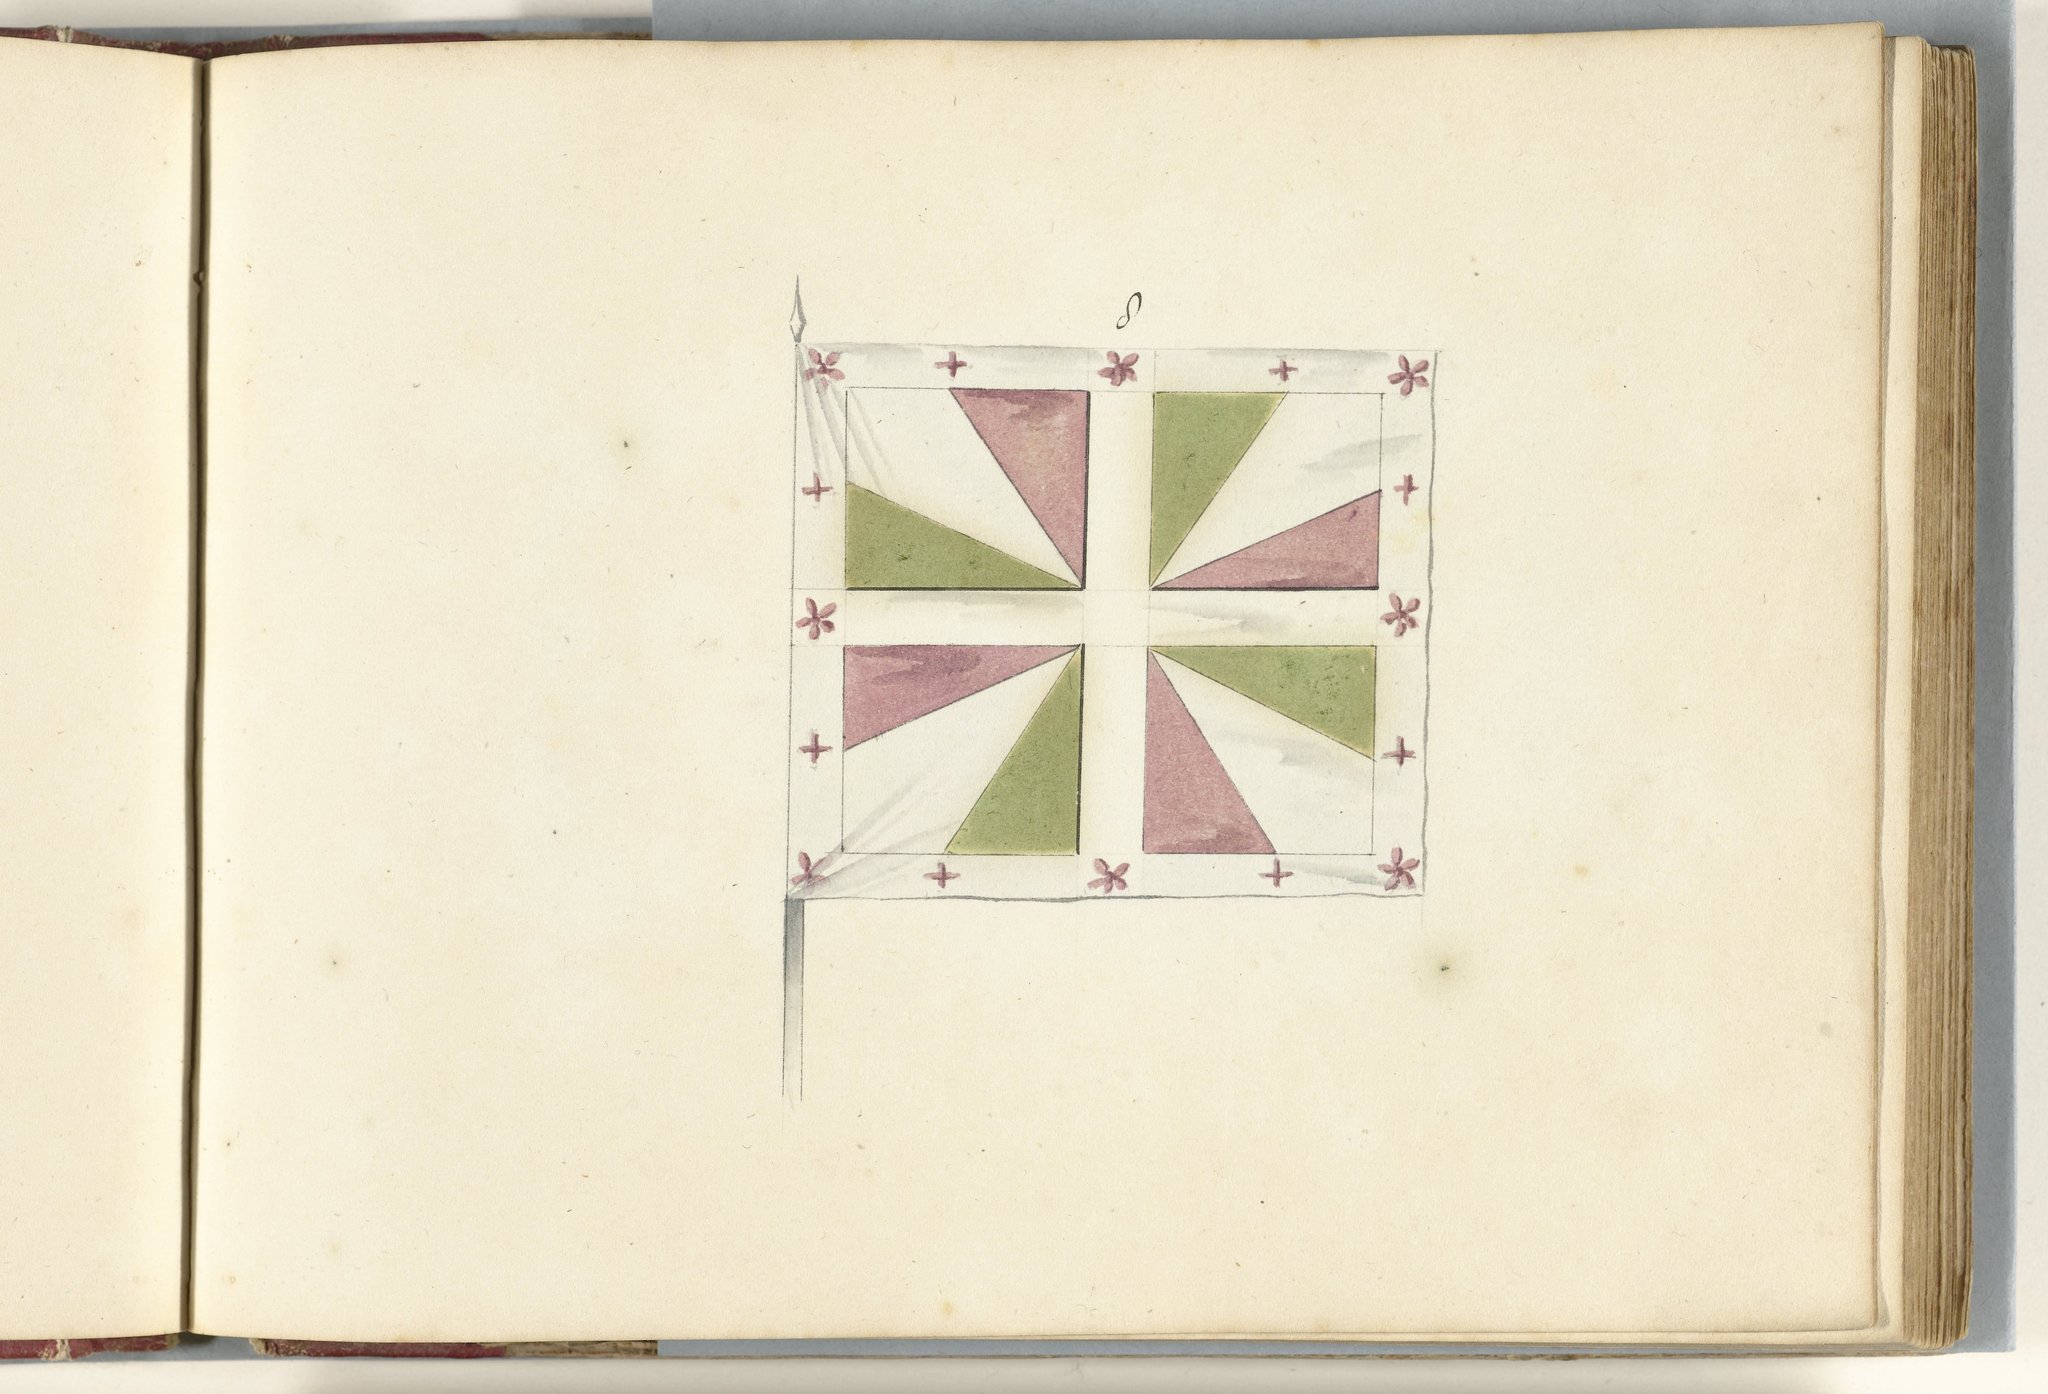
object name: drawing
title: Frans vaandel veroverd in de slag bij Oudenaarde, 1708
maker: Anonymous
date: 1713-1720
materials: paper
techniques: drawing, writing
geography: northern netherlands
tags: (military) flags and standards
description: Frans vaandel veroverd bij de slag bij Oudenaarde in 1708. In het boek met tekeningen van Franse vaandels, standaarden en pauken, veroverd tijdens de Spaanse Successieoorlog (1701-1713).